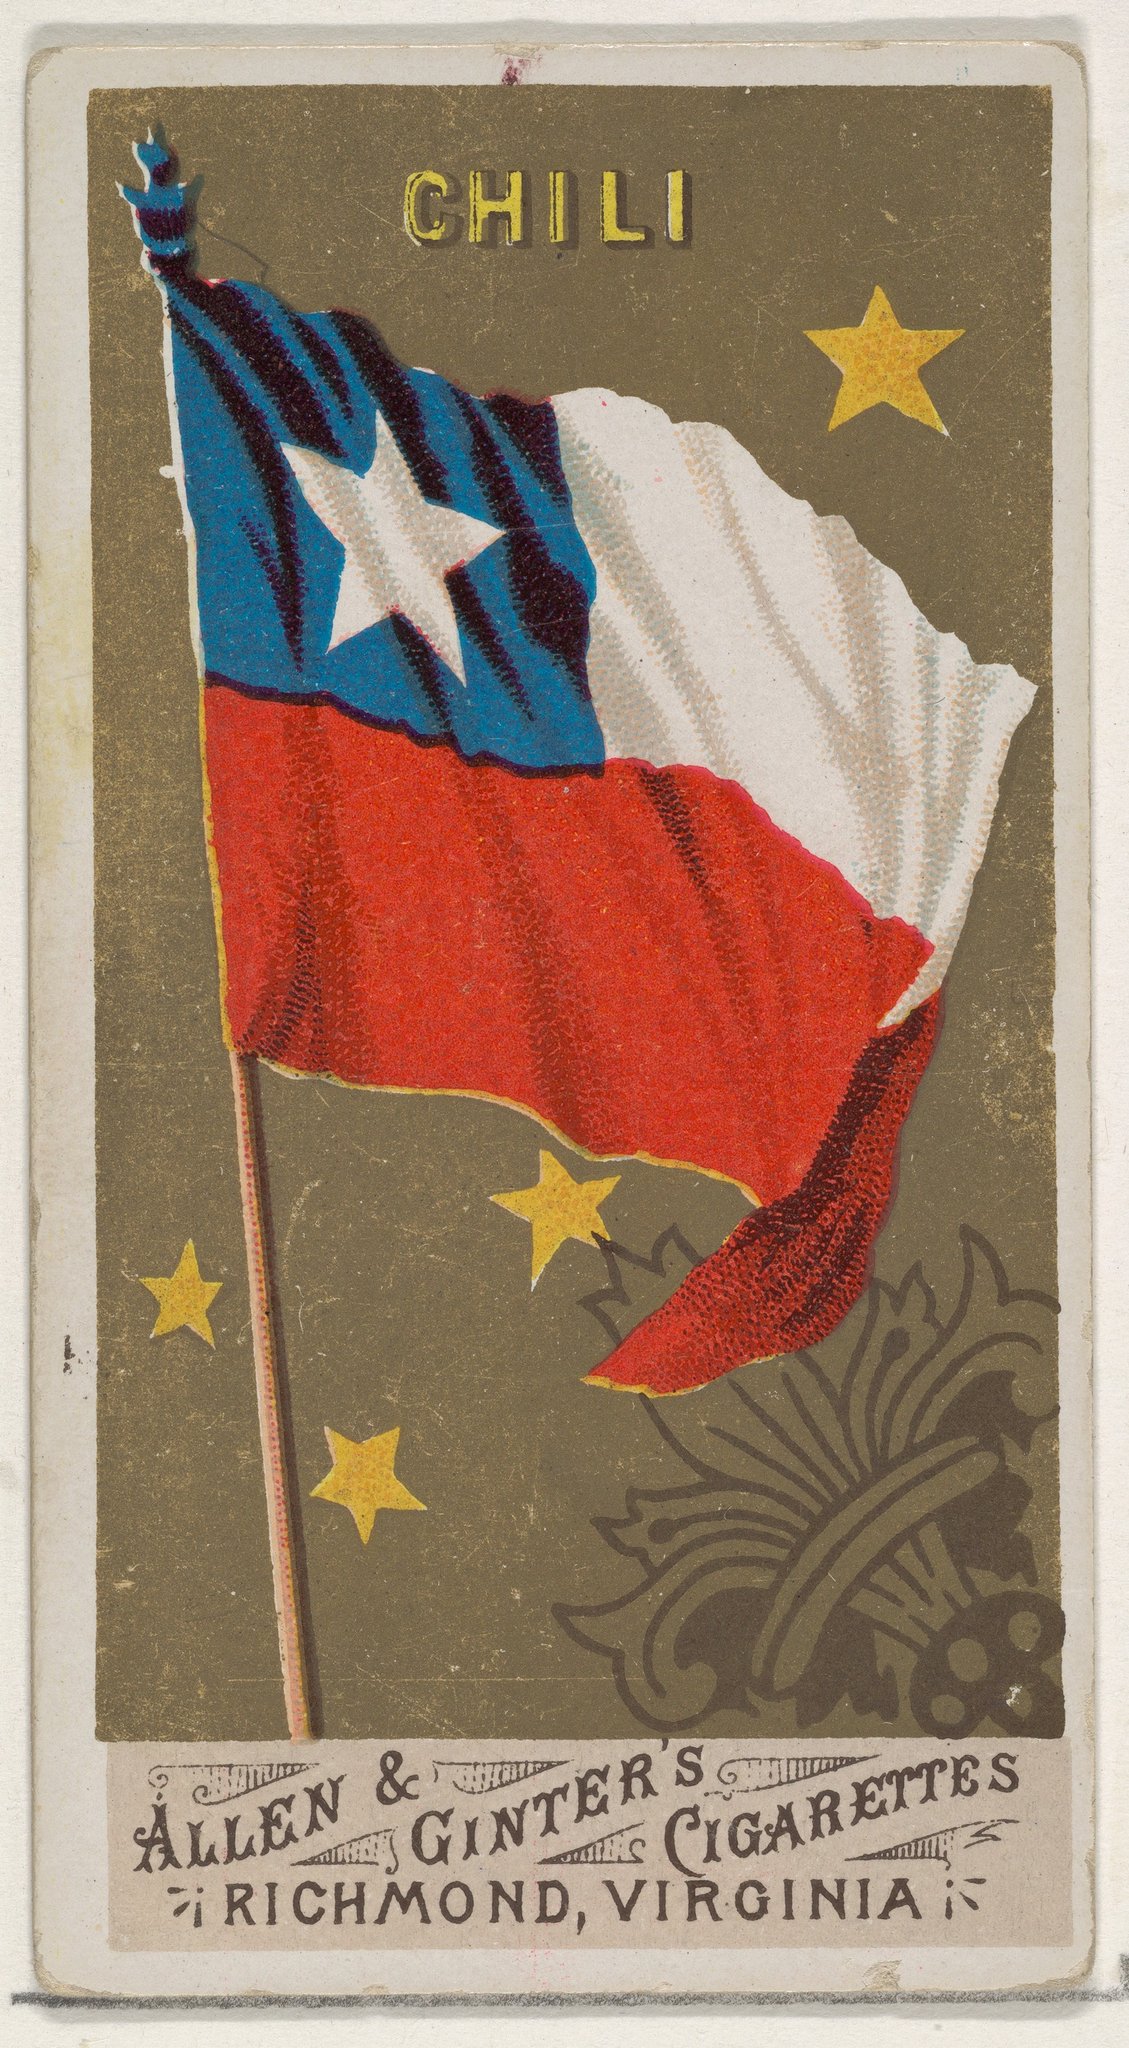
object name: print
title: Chile, from Flags of All Nations, Series 1 (N9) for Allen & Ginter Cigarettes Brands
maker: allen & ginter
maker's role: publisher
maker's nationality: american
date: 1887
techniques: color lithograph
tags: flags